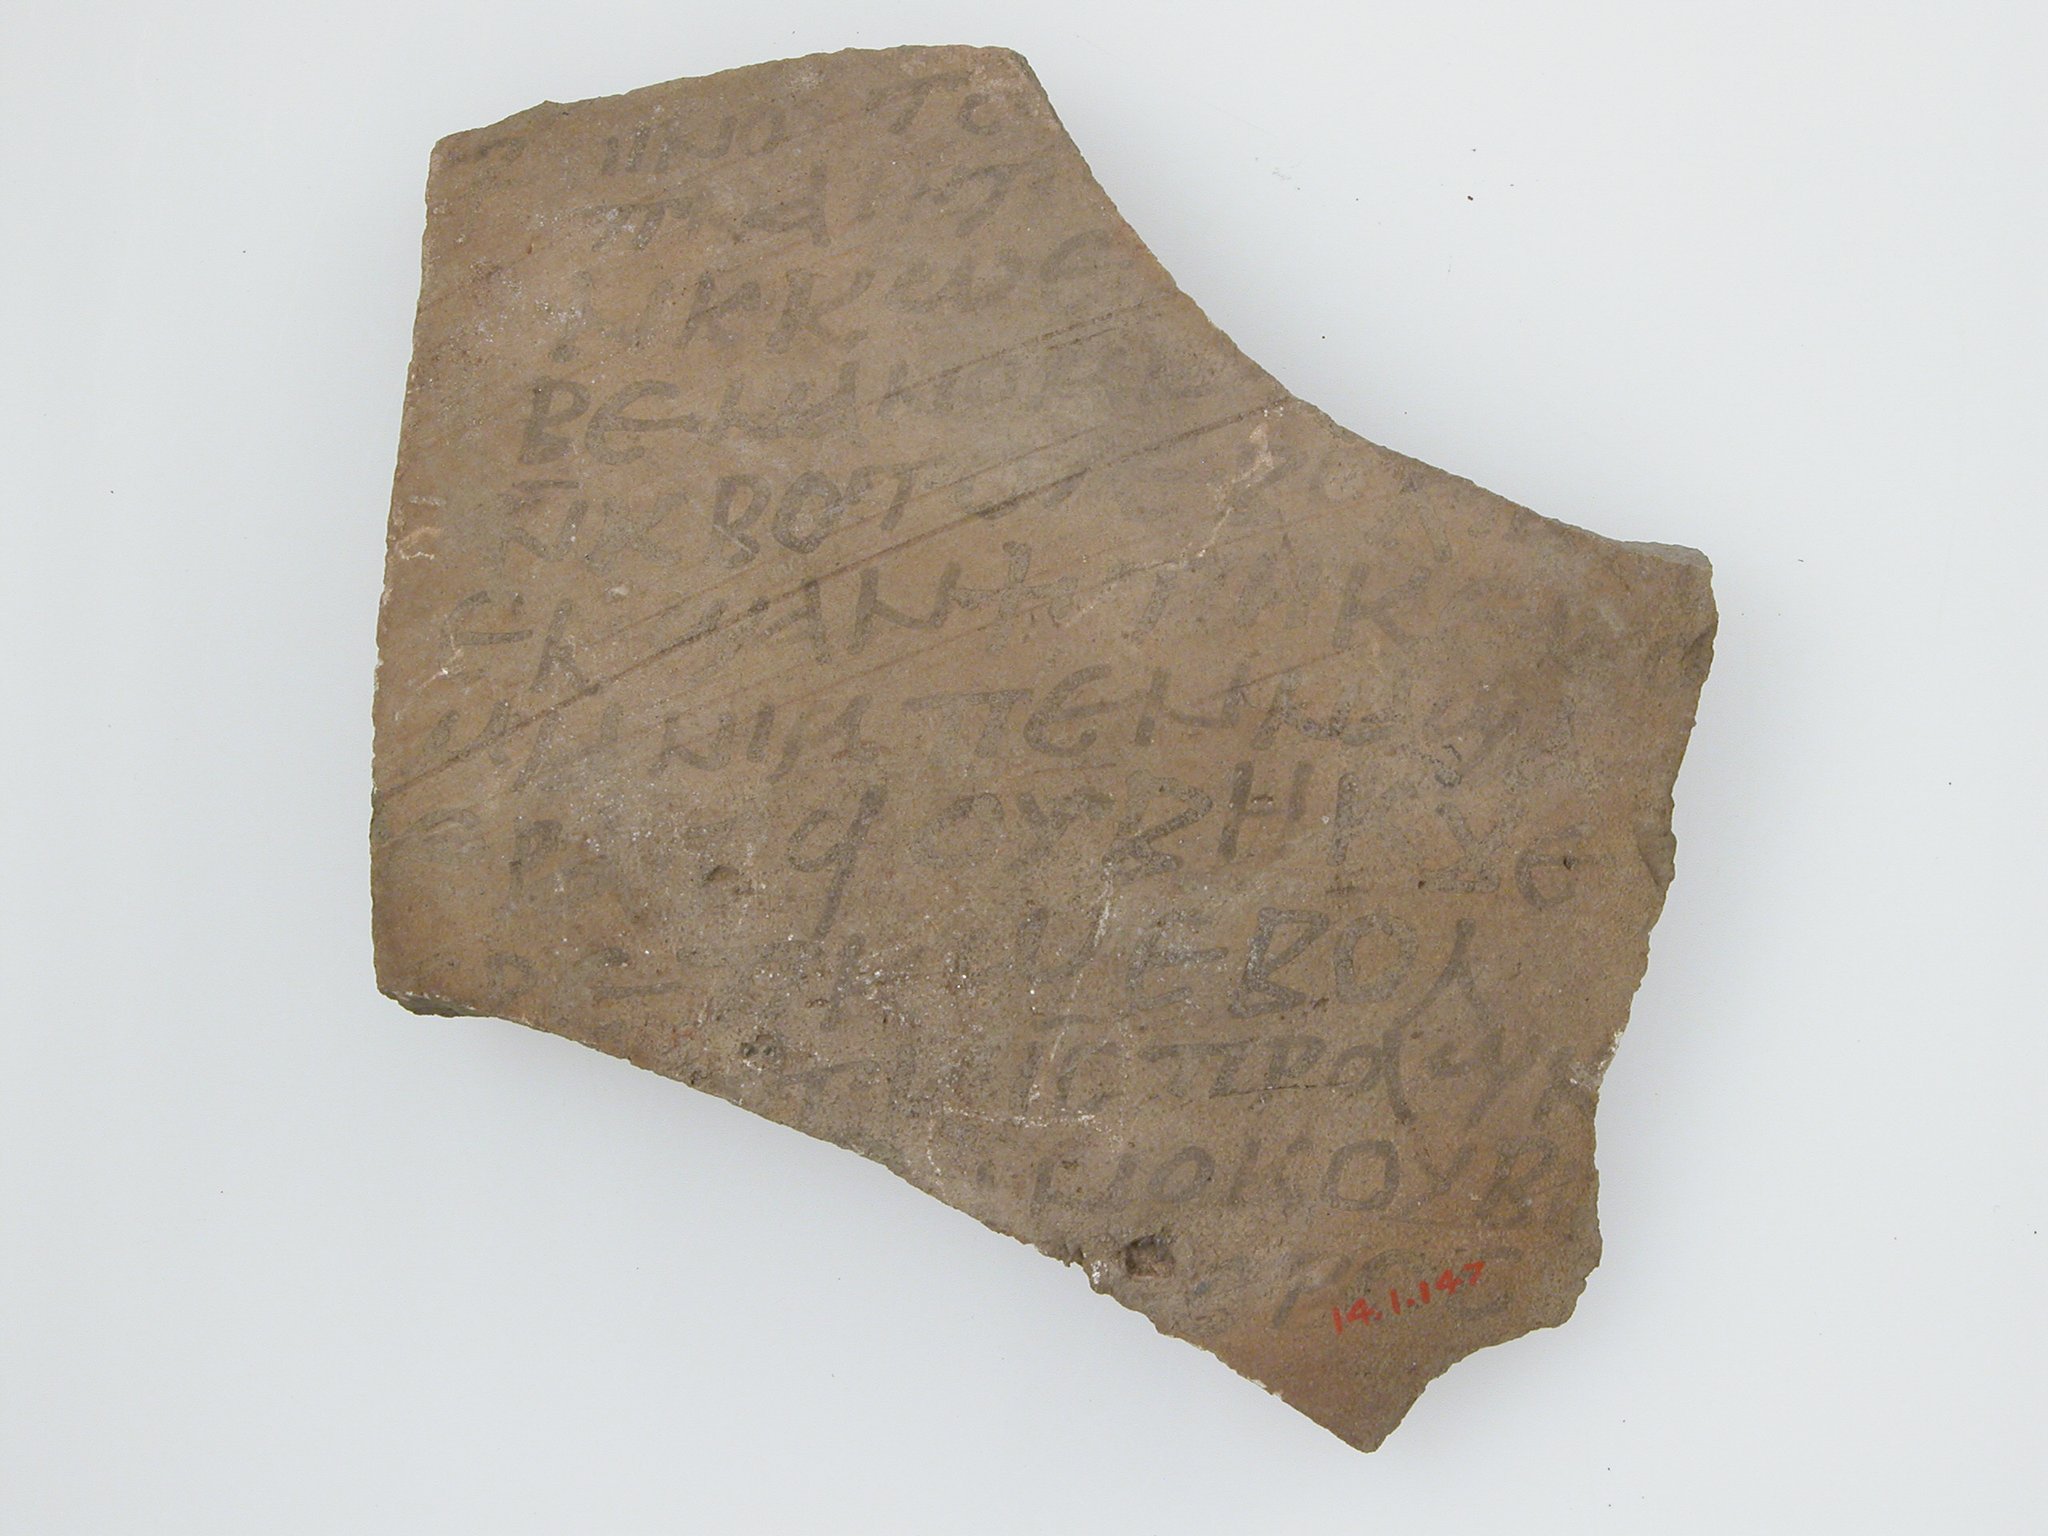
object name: ostrakon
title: Ostrakon with Liturgical Text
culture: coptic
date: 600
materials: ink, pottery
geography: egypt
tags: coptic